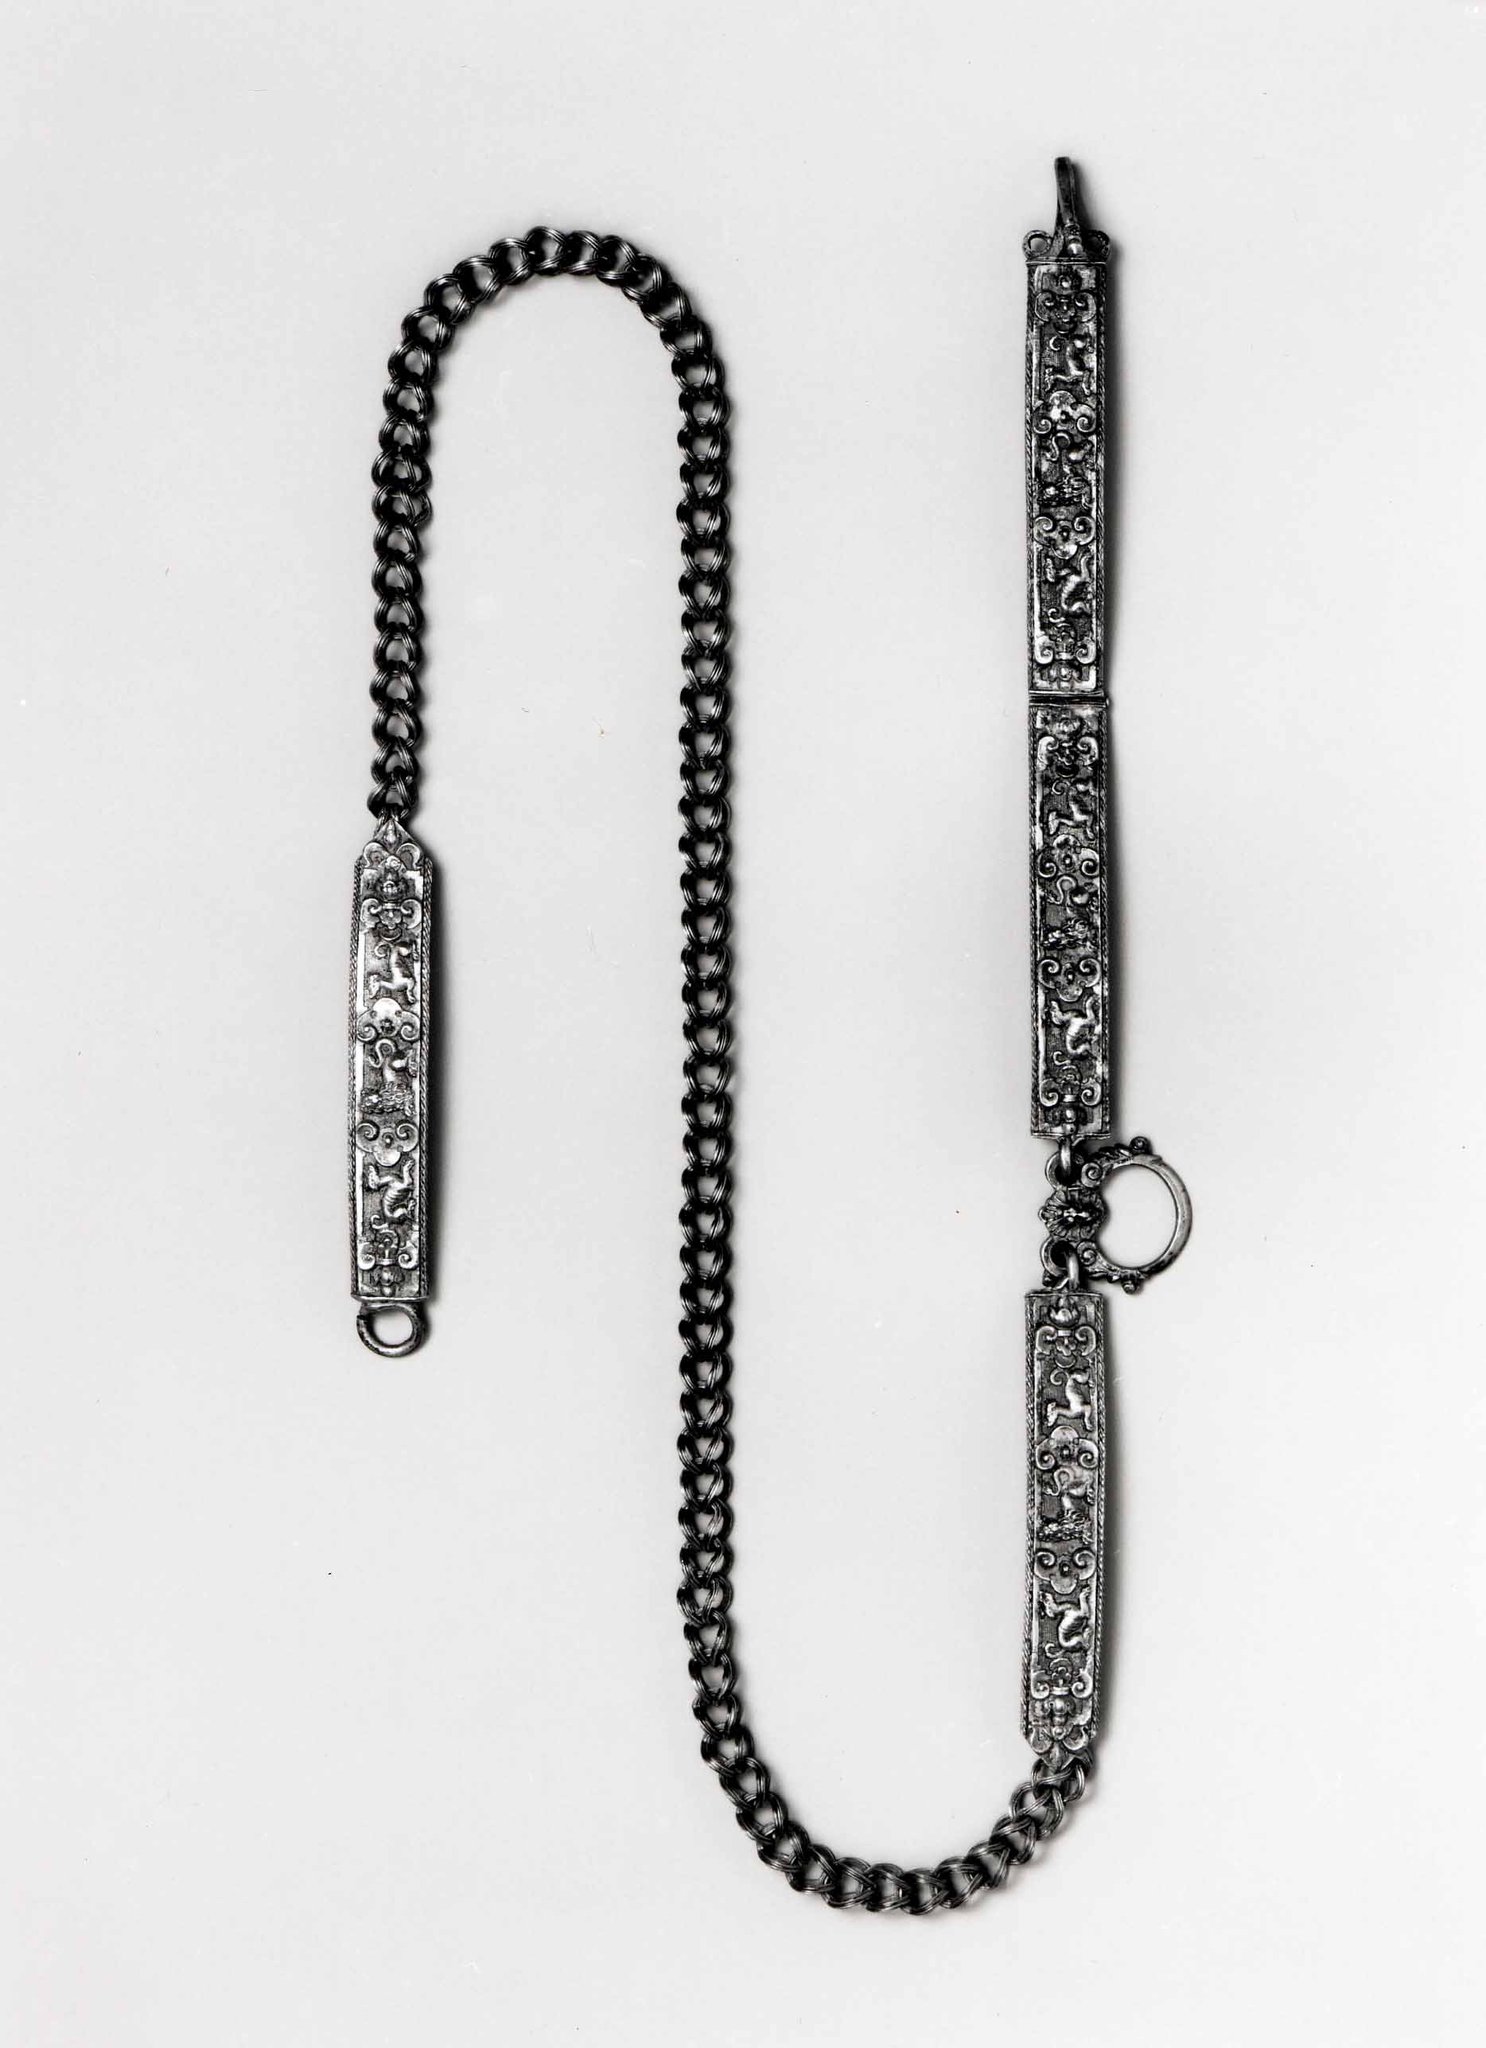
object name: belt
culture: german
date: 1867-1900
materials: silver